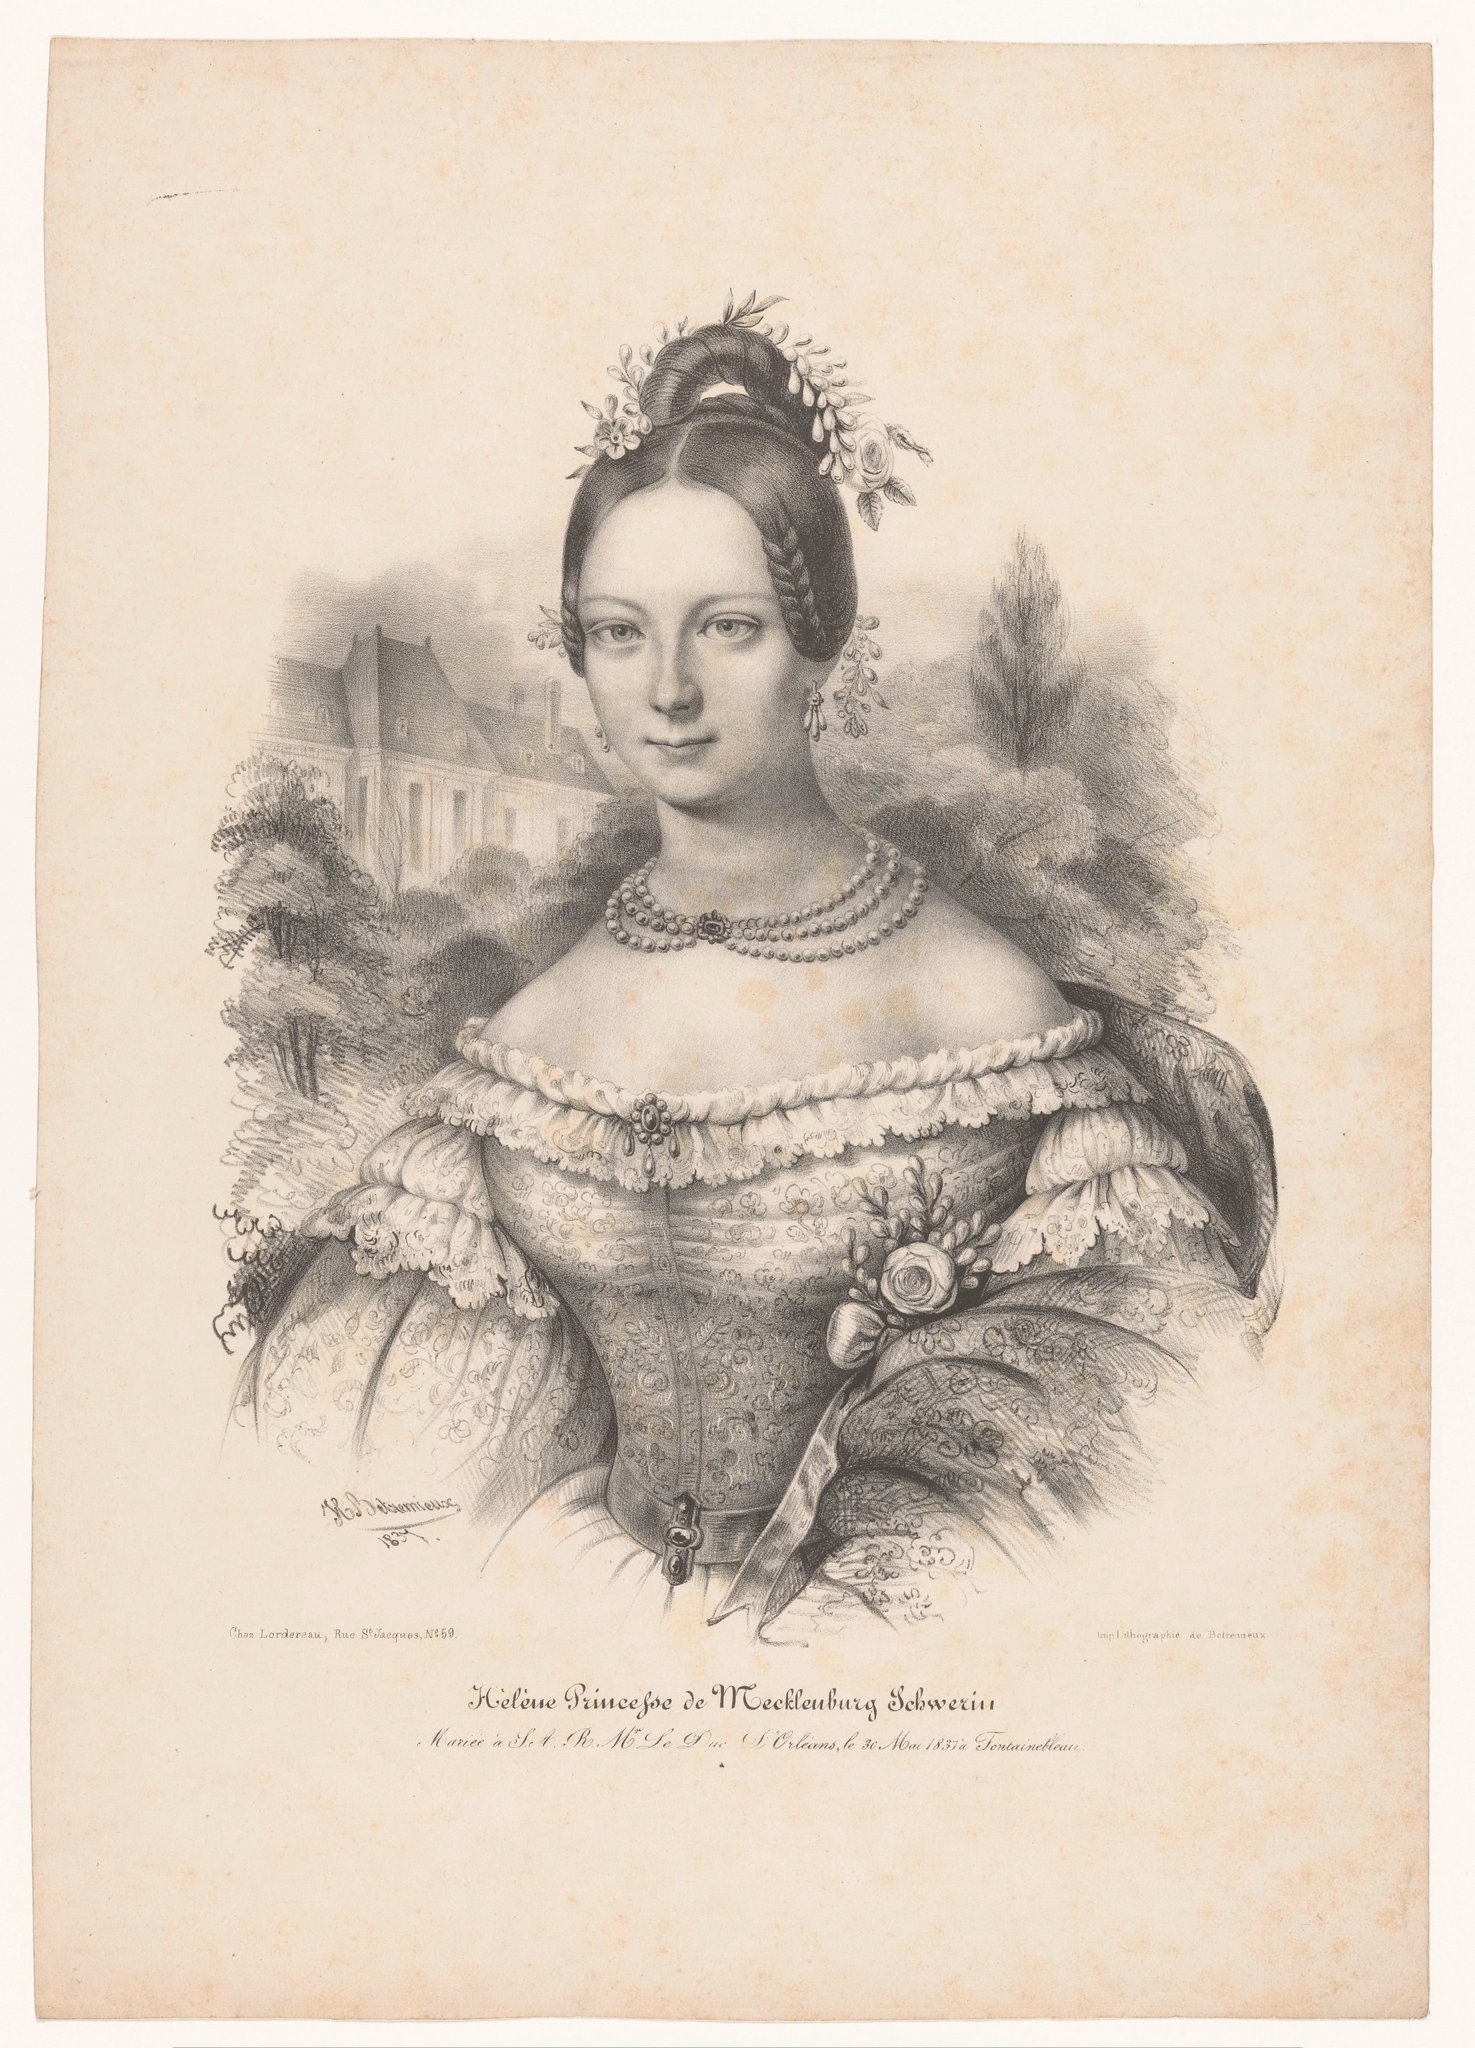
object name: print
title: Hélène princesse de Mecklenburg Schwerin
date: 1837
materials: paper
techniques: lithograph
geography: paris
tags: helene van mecklenburg-schwerin, historical persons - bb - woman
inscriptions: collector's mark: Lugt 2228